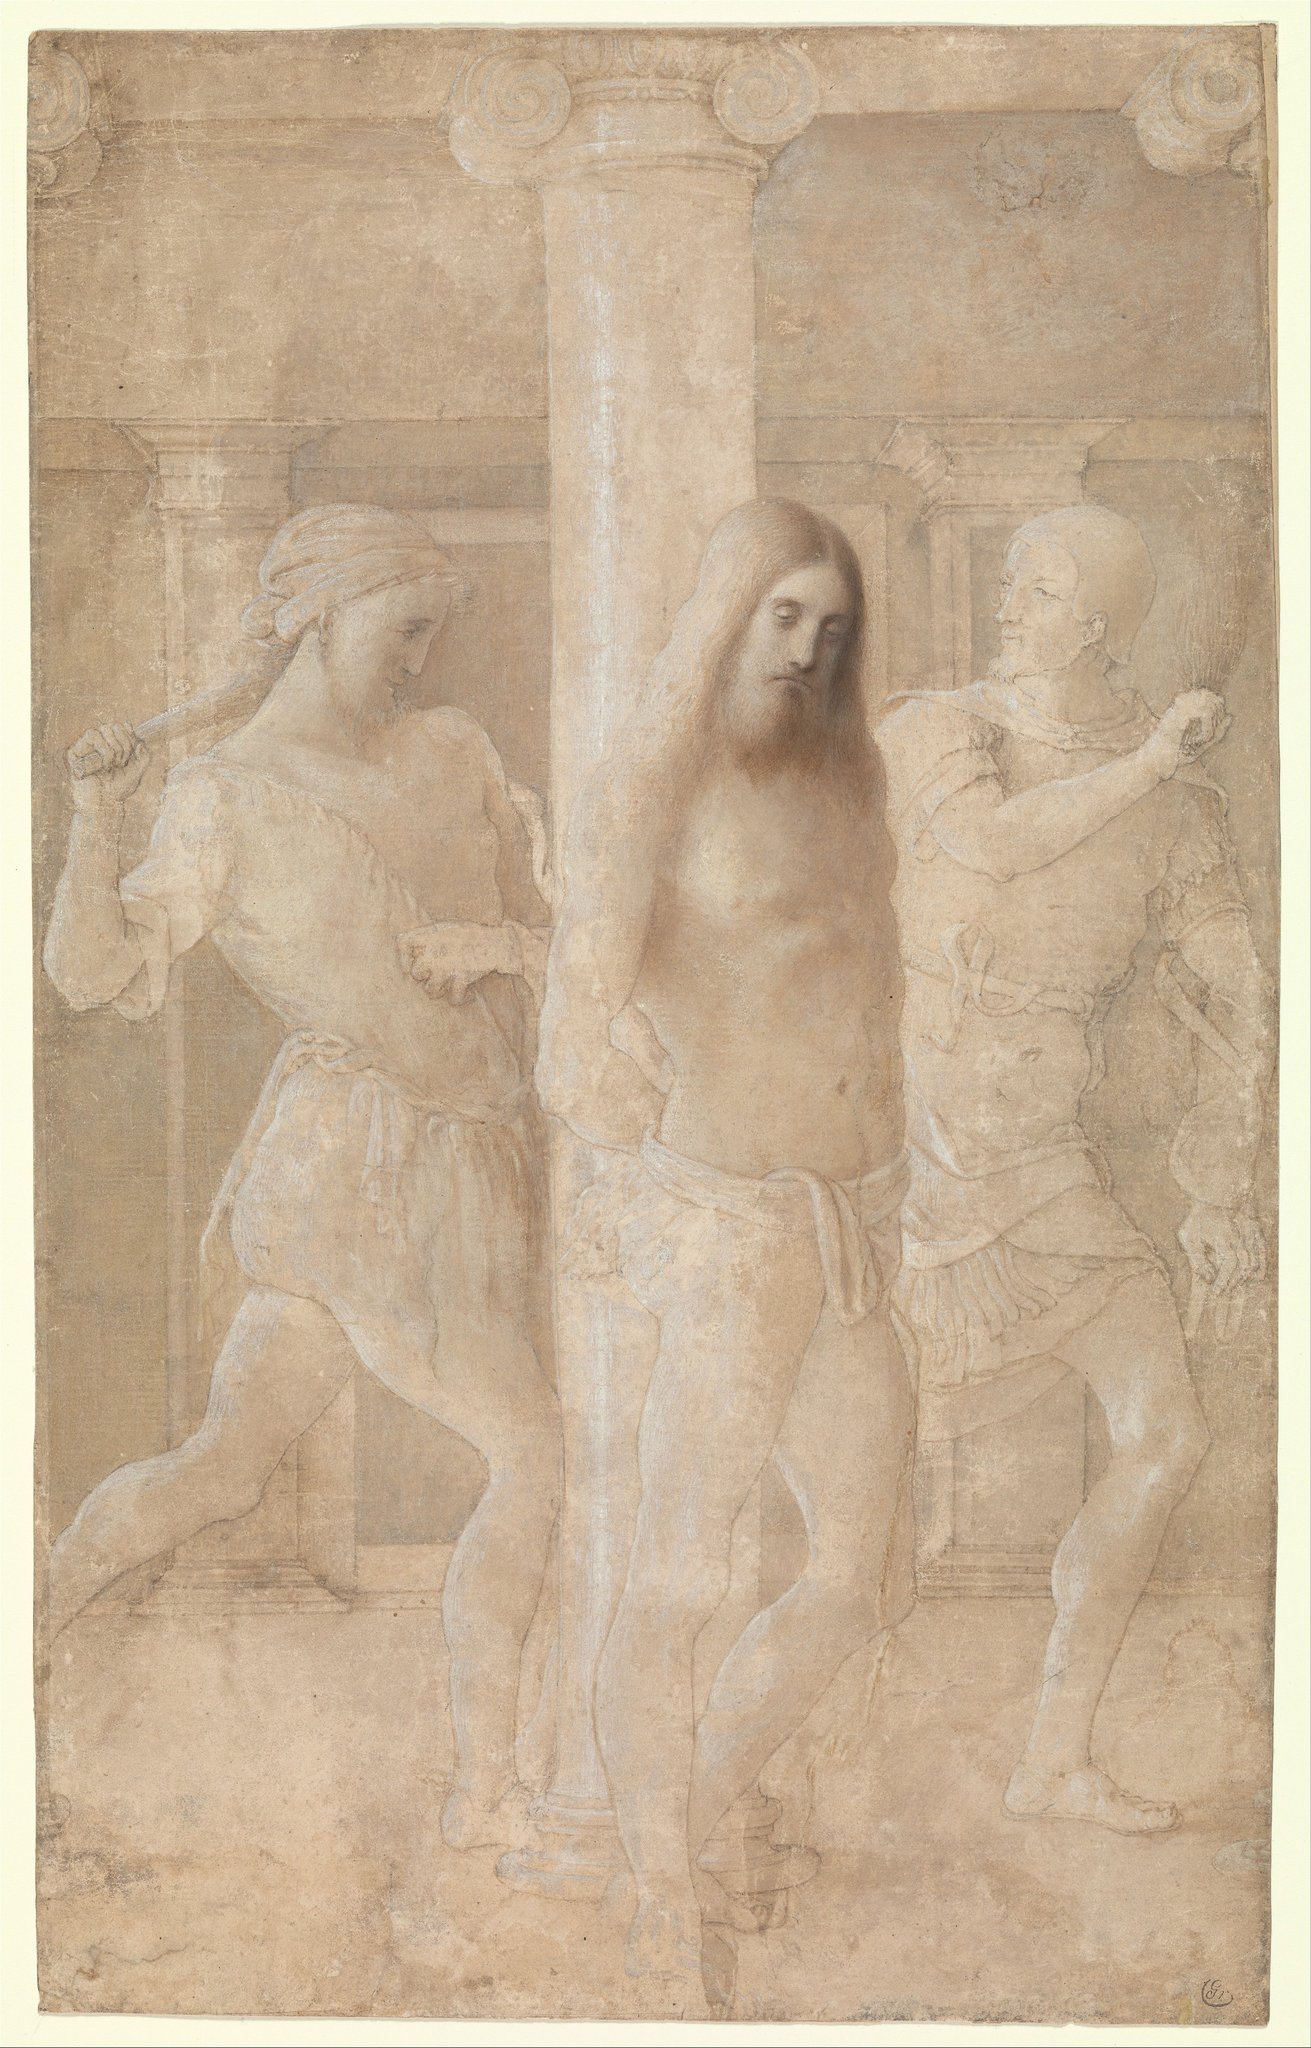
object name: drawing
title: The Flagellation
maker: lombardy (?)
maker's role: artist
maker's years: 1470-1499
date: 1467-1500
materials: chalk, ink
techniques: brush, heightening, wash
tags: men,christ